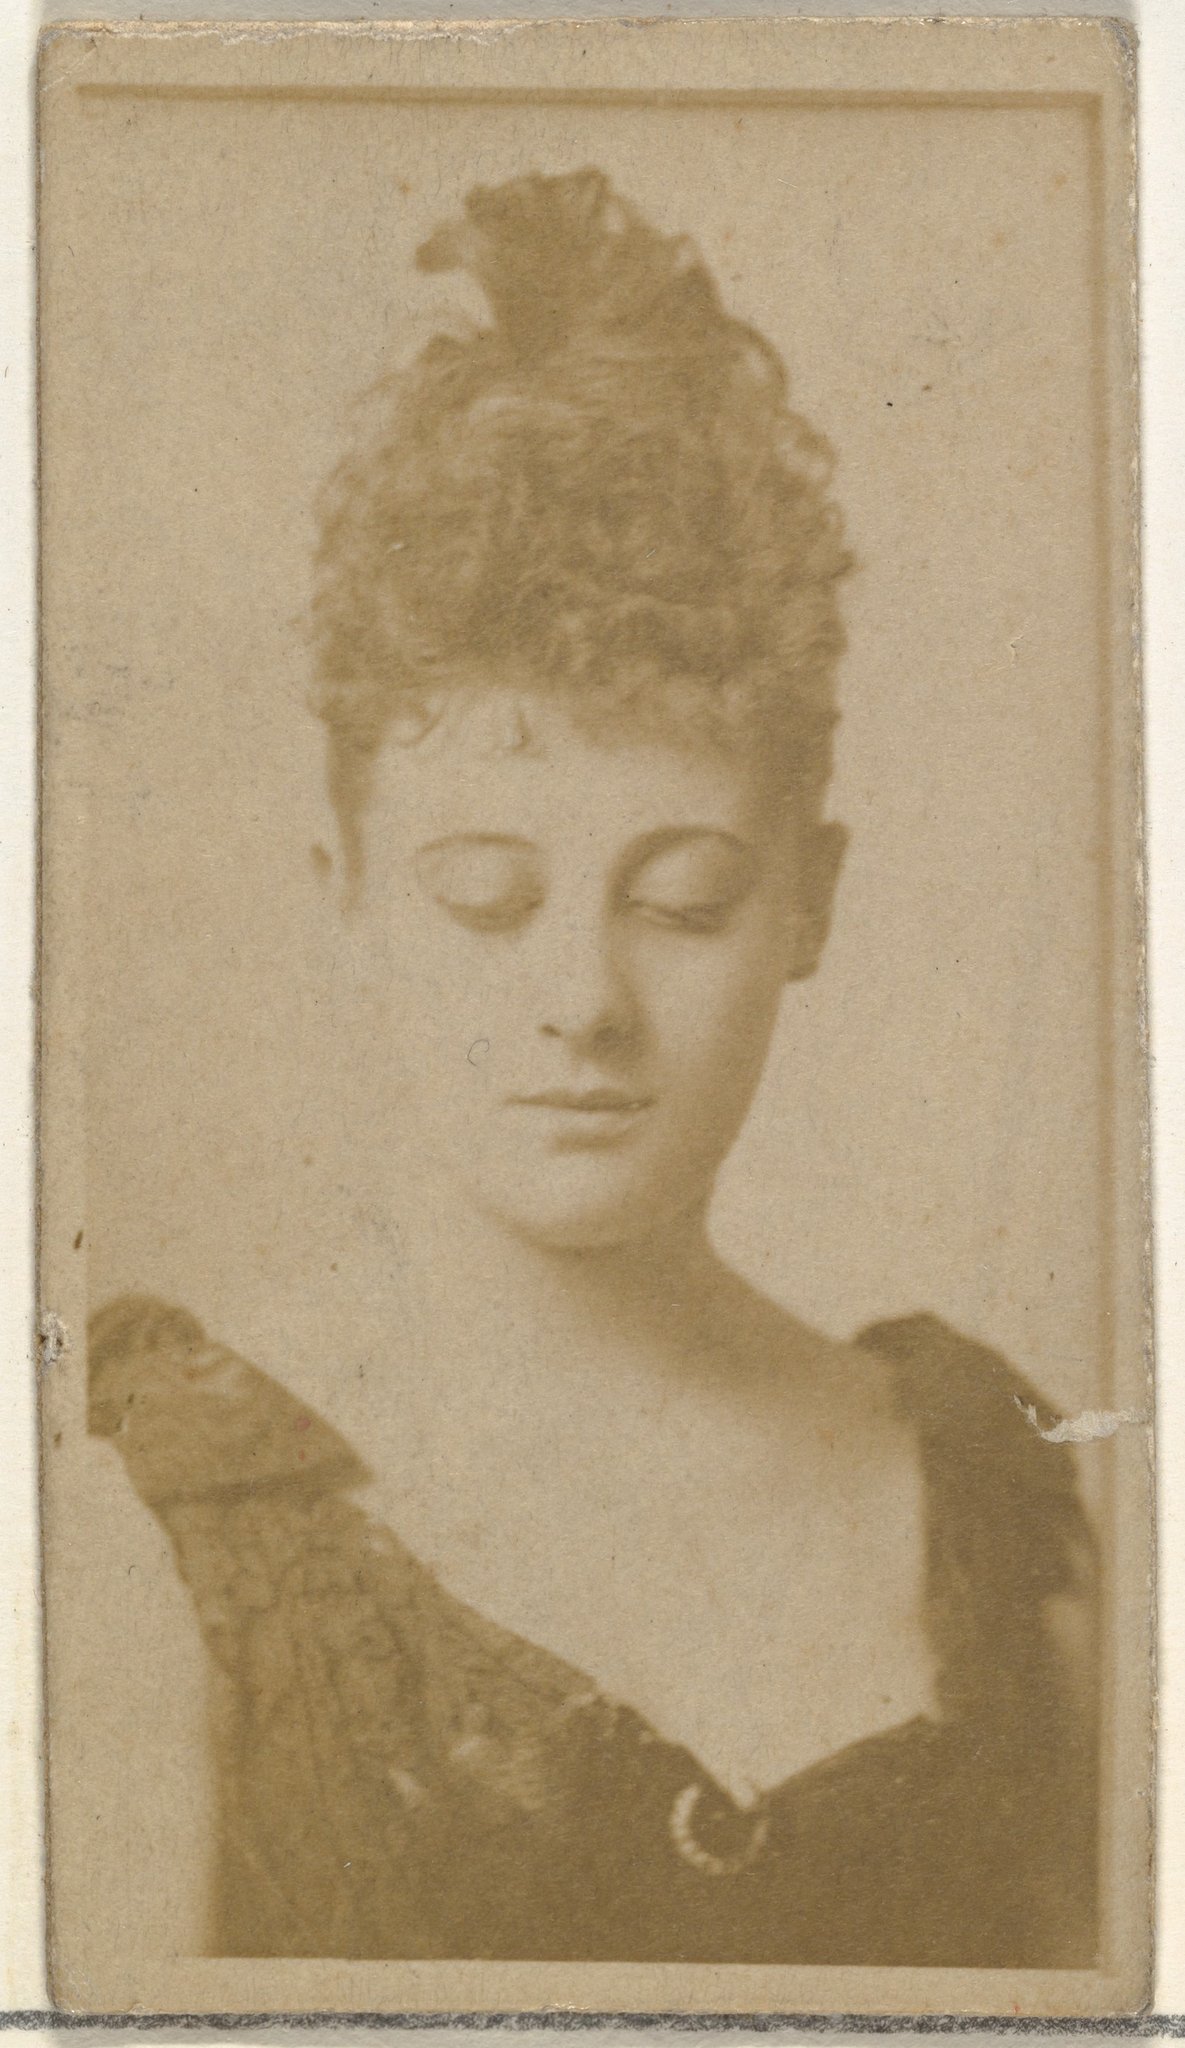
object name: photograph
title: [Actress with downcast eyes], from the Actors and Actresses series (N145-8) issued by Duke Sons & Co. to promote Duke Cigarettes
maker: w. duke, sons & co.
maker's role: publisher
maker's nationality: american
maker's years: 1870-1920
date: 1891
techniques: albumen silver print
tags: portraits,women,actresses